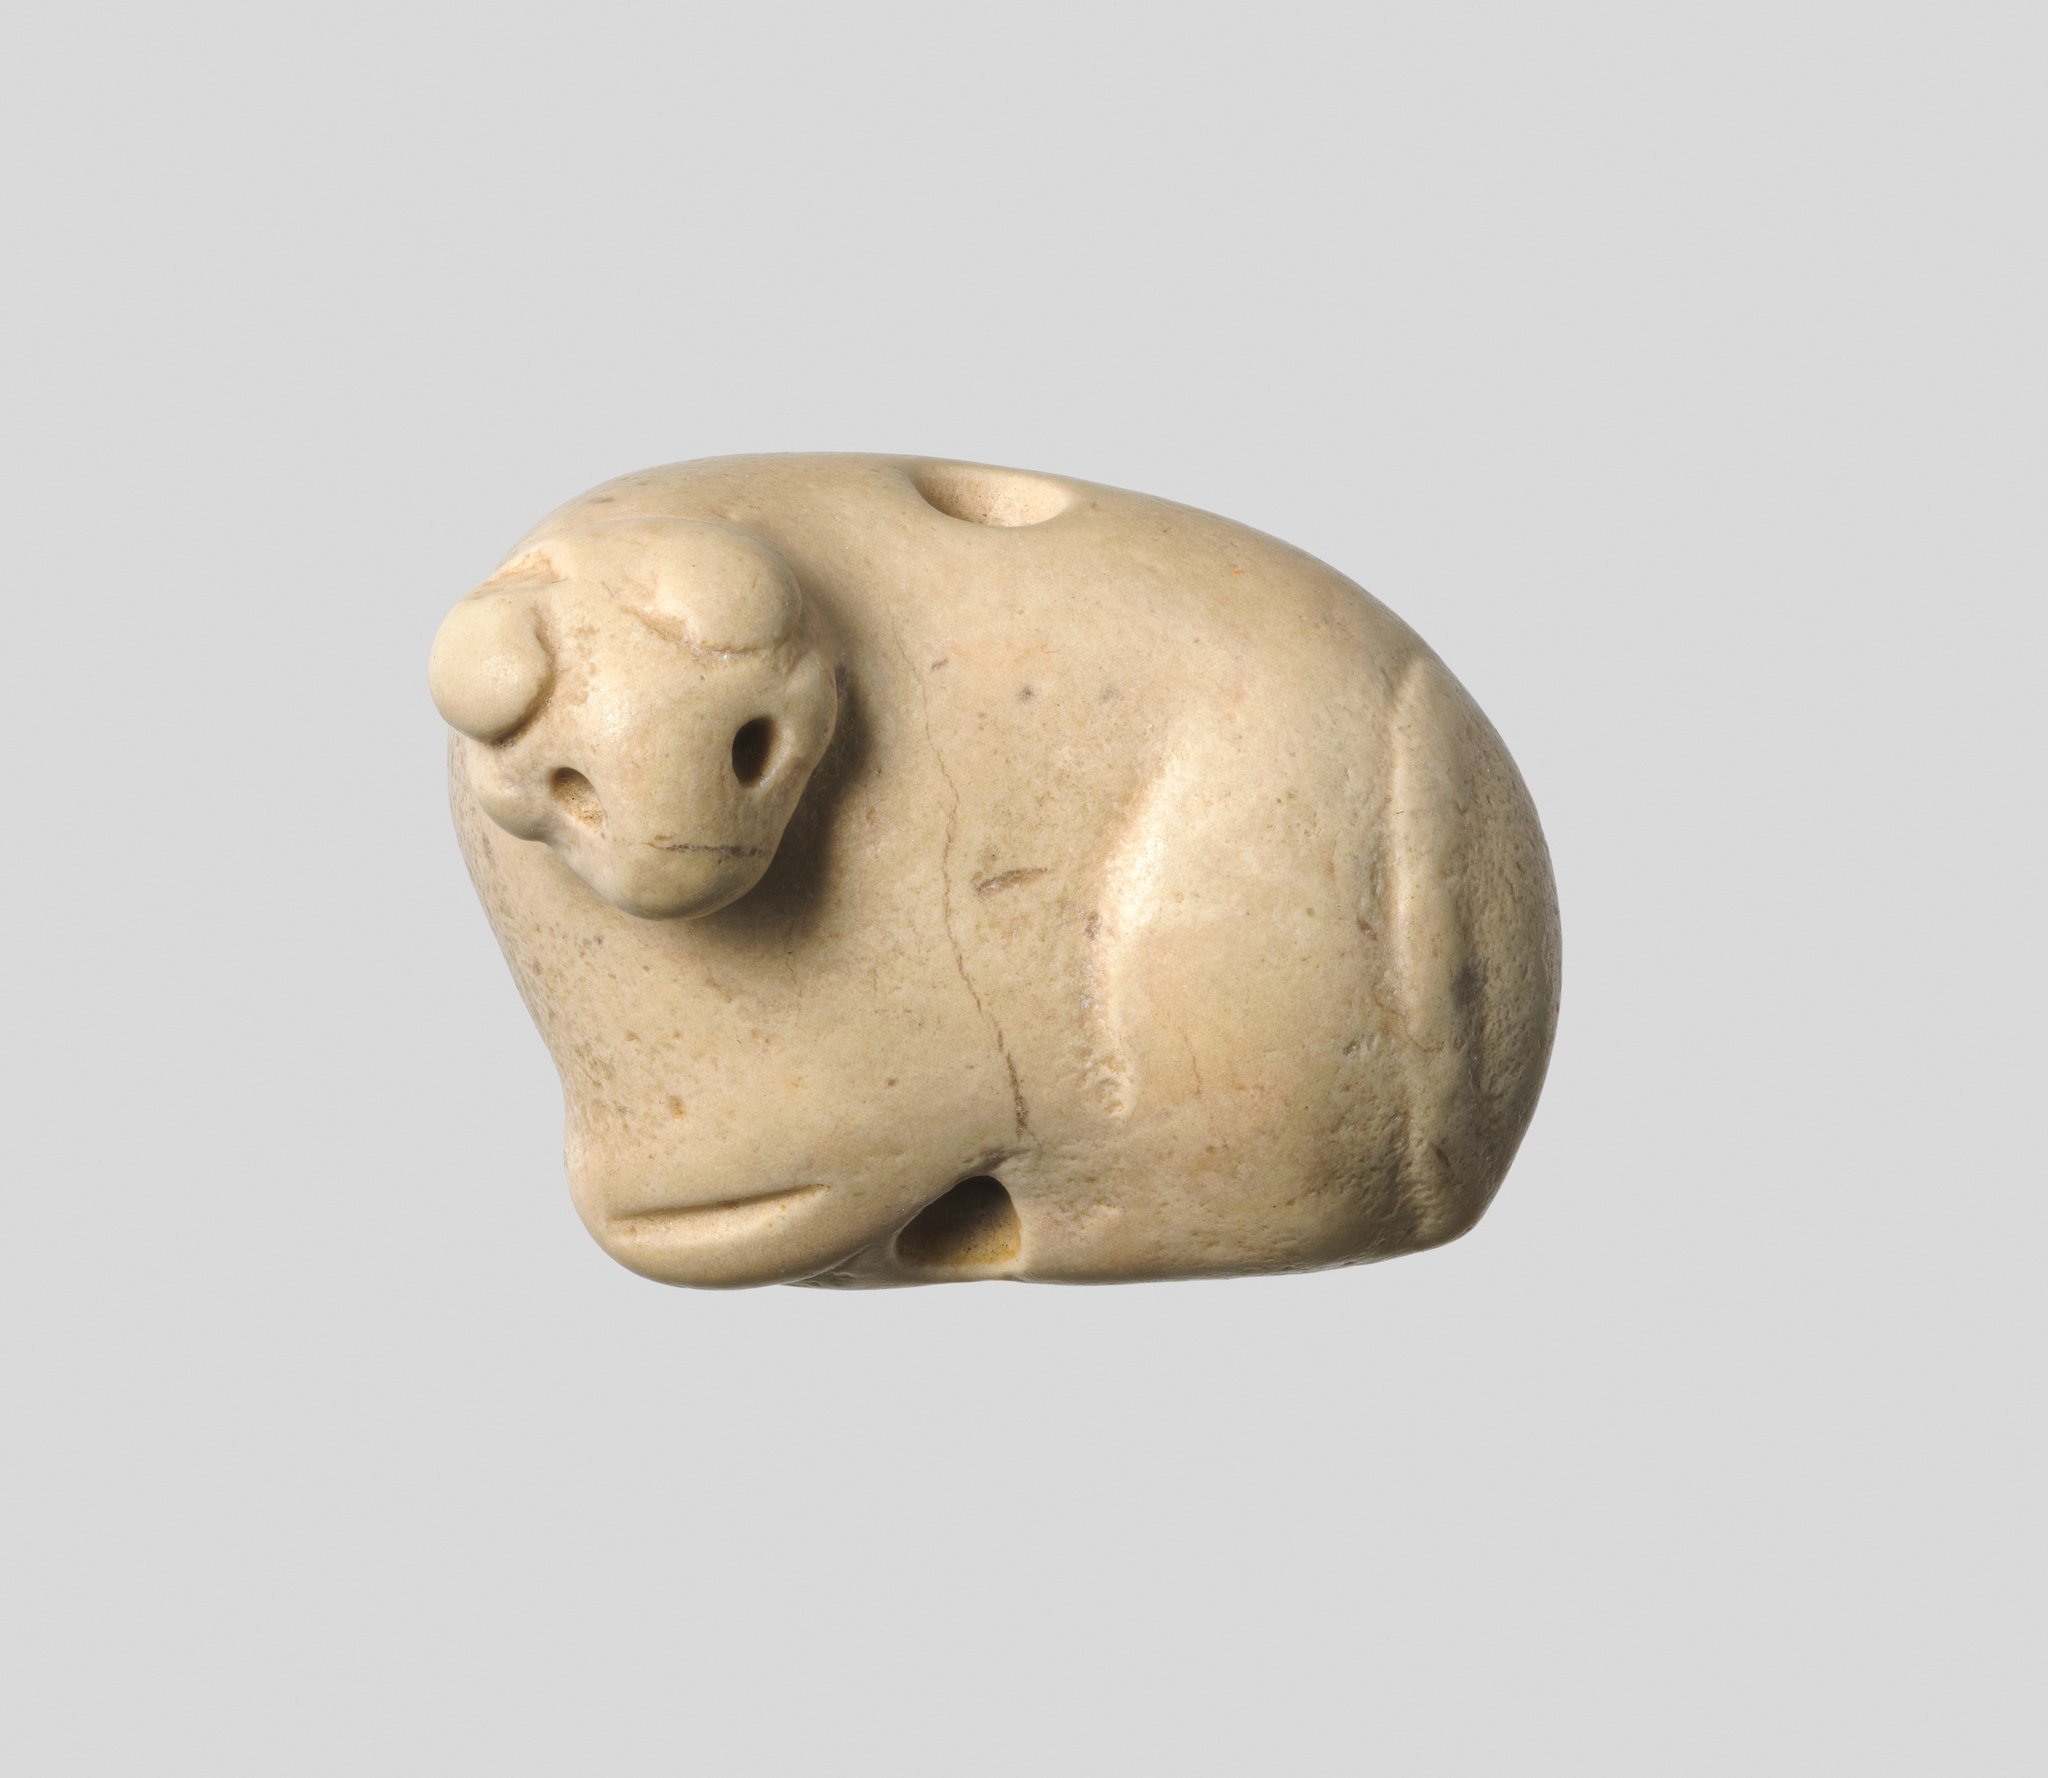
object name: stamp seal amulet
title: Seal amulet in the form of a recumbent bovid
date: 3500-2900 BCE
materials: stone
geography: mesopotamia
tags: animals